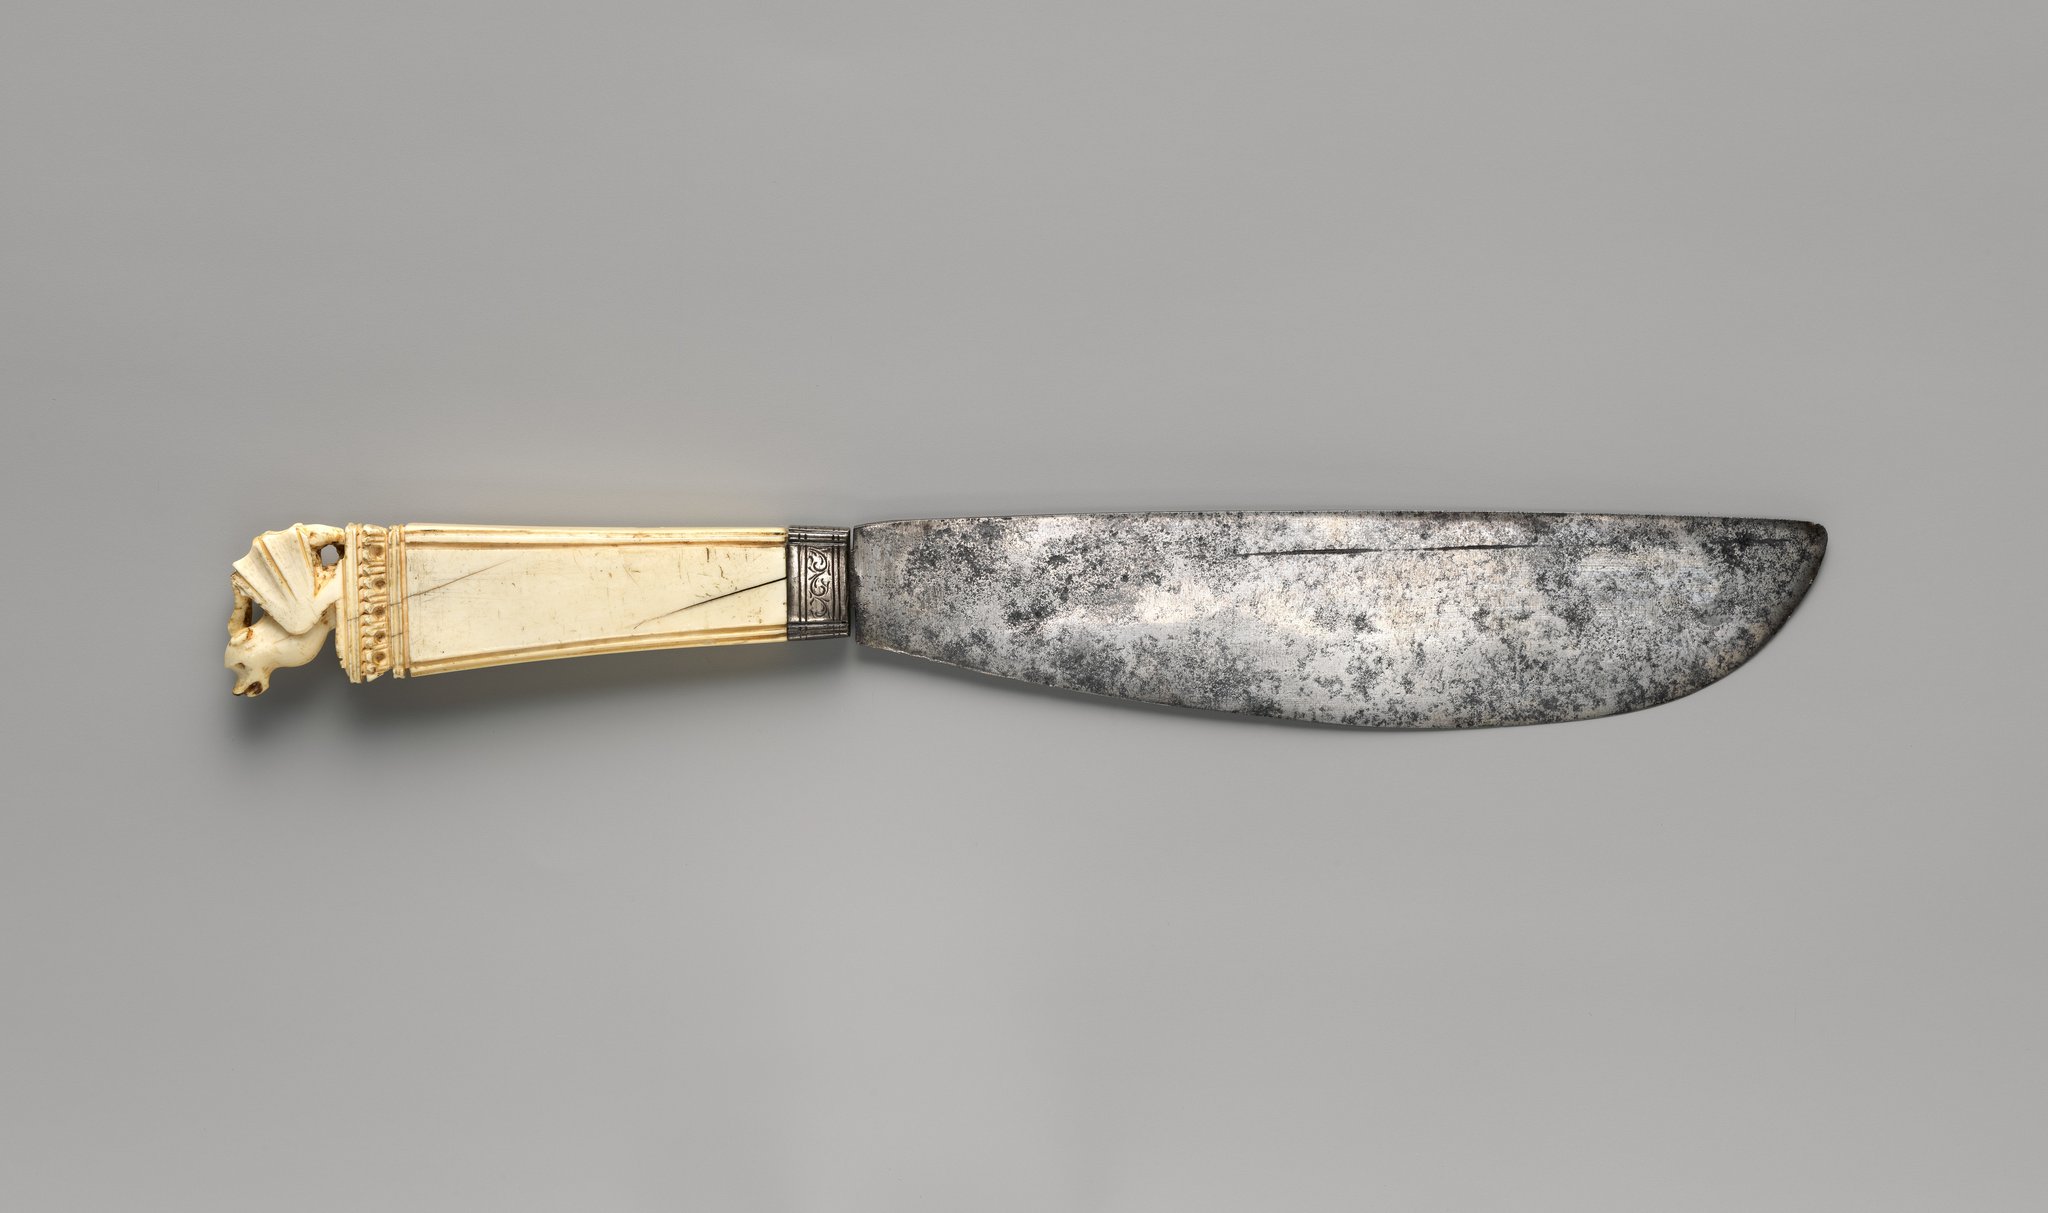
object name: knife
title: Steel Knife with Ivory Handle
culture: italian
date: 1301-1400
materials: ivory, steel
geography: italy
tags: animals